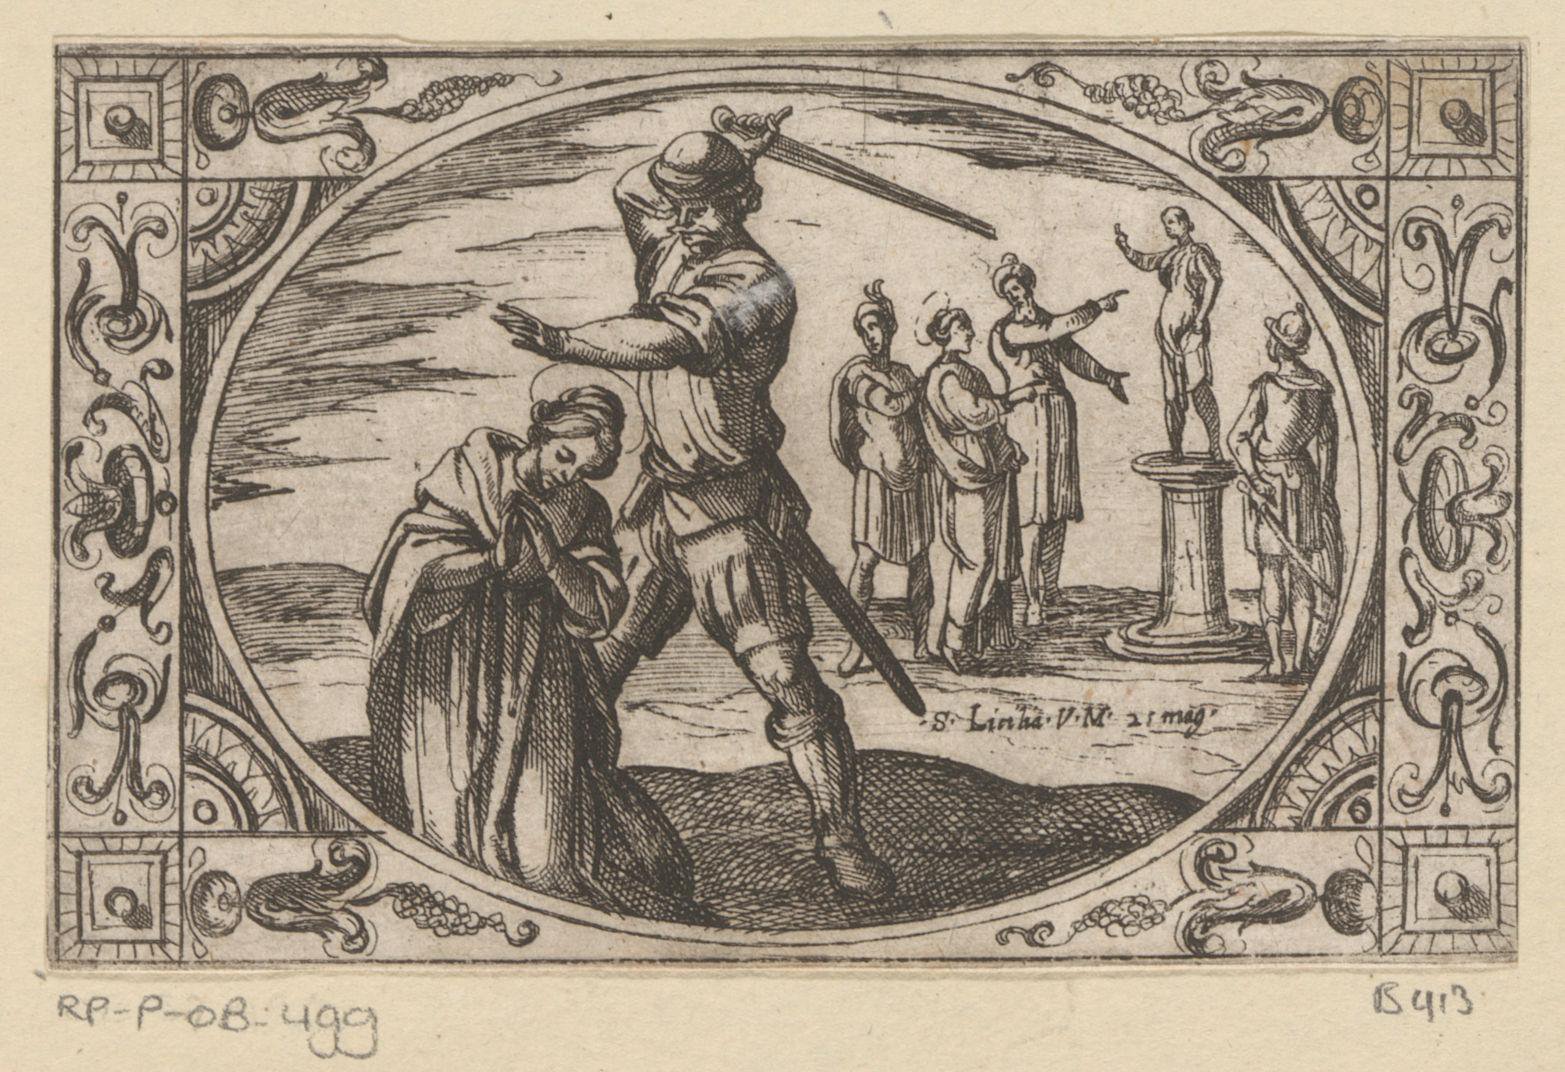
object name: print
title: H. Licinia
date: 1565-1630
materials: paper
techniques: etching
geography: rome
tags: martyr(s) (often with palm-branches) - qq - female martyr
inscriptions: collector's mark: Lugt 240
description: Deze prent maakt deel uit van een reeks van 73 prenten (+ titelprent) met voorstellingen van Romeinse martelaressen.